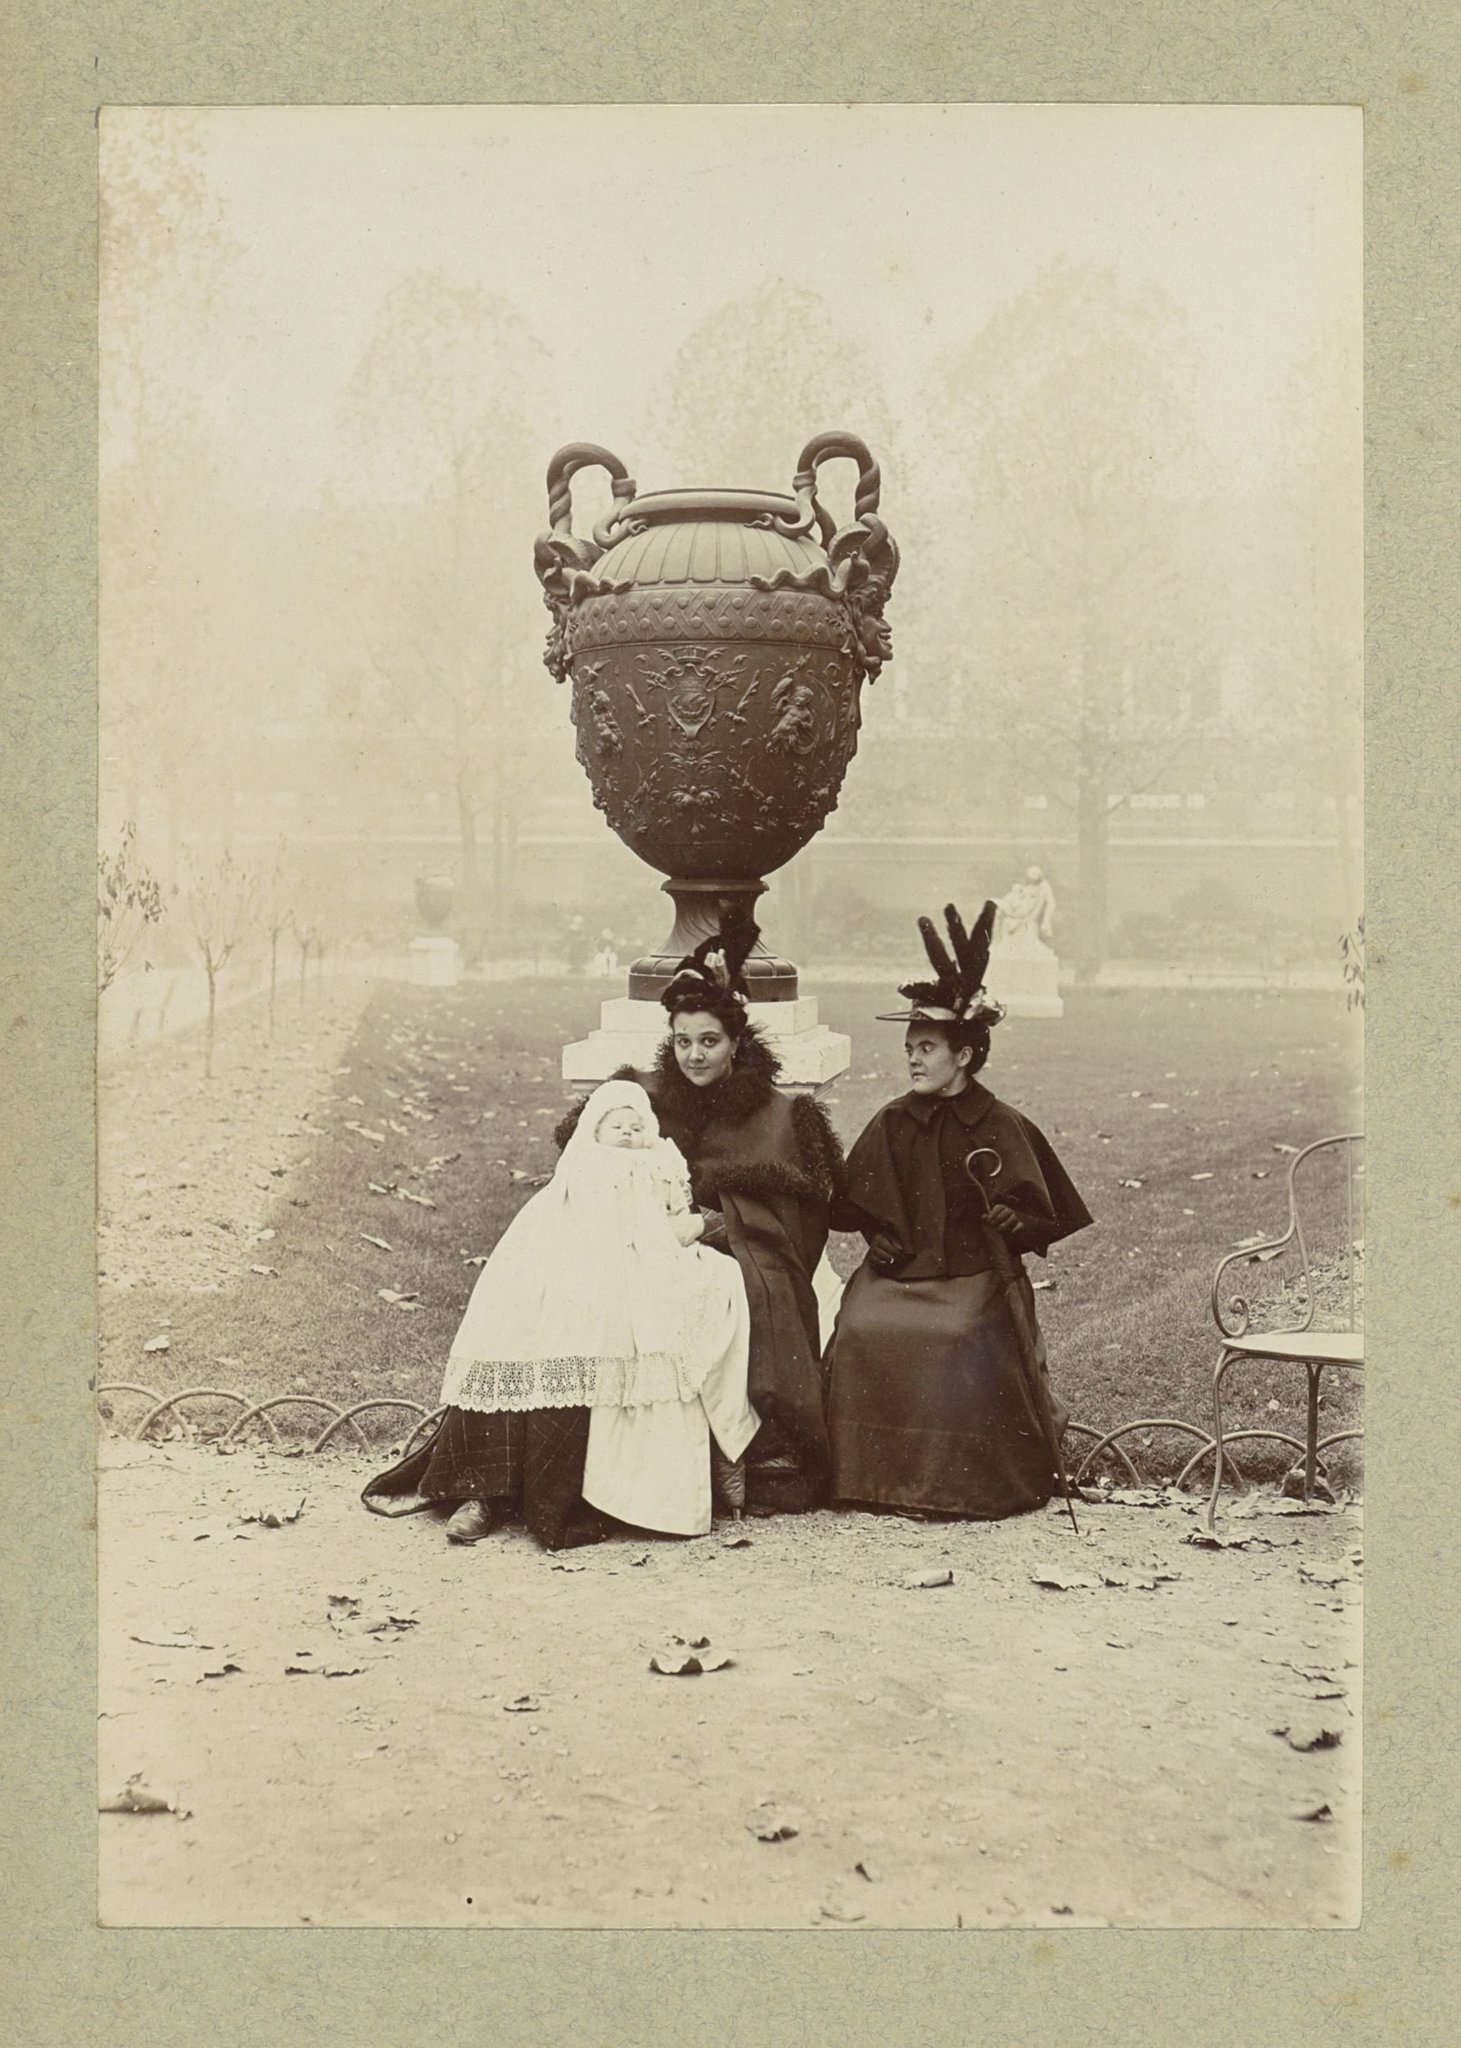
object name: photograph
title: Twee vrouwen en een baby in een park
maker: Anonymous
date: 1885-1914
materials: photographic support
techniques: gelatin silver print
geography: france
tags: mother and baby or young child, public gardens, park, garden vase, france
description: Onderdeel van Fotoalbum met familiefoto's.